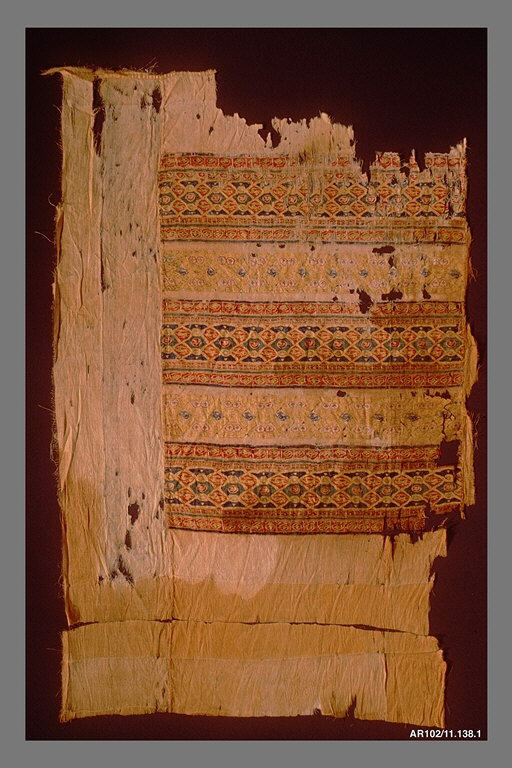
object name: textile fragment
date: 1001-1100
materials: linen, silk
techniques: weave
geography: egypt